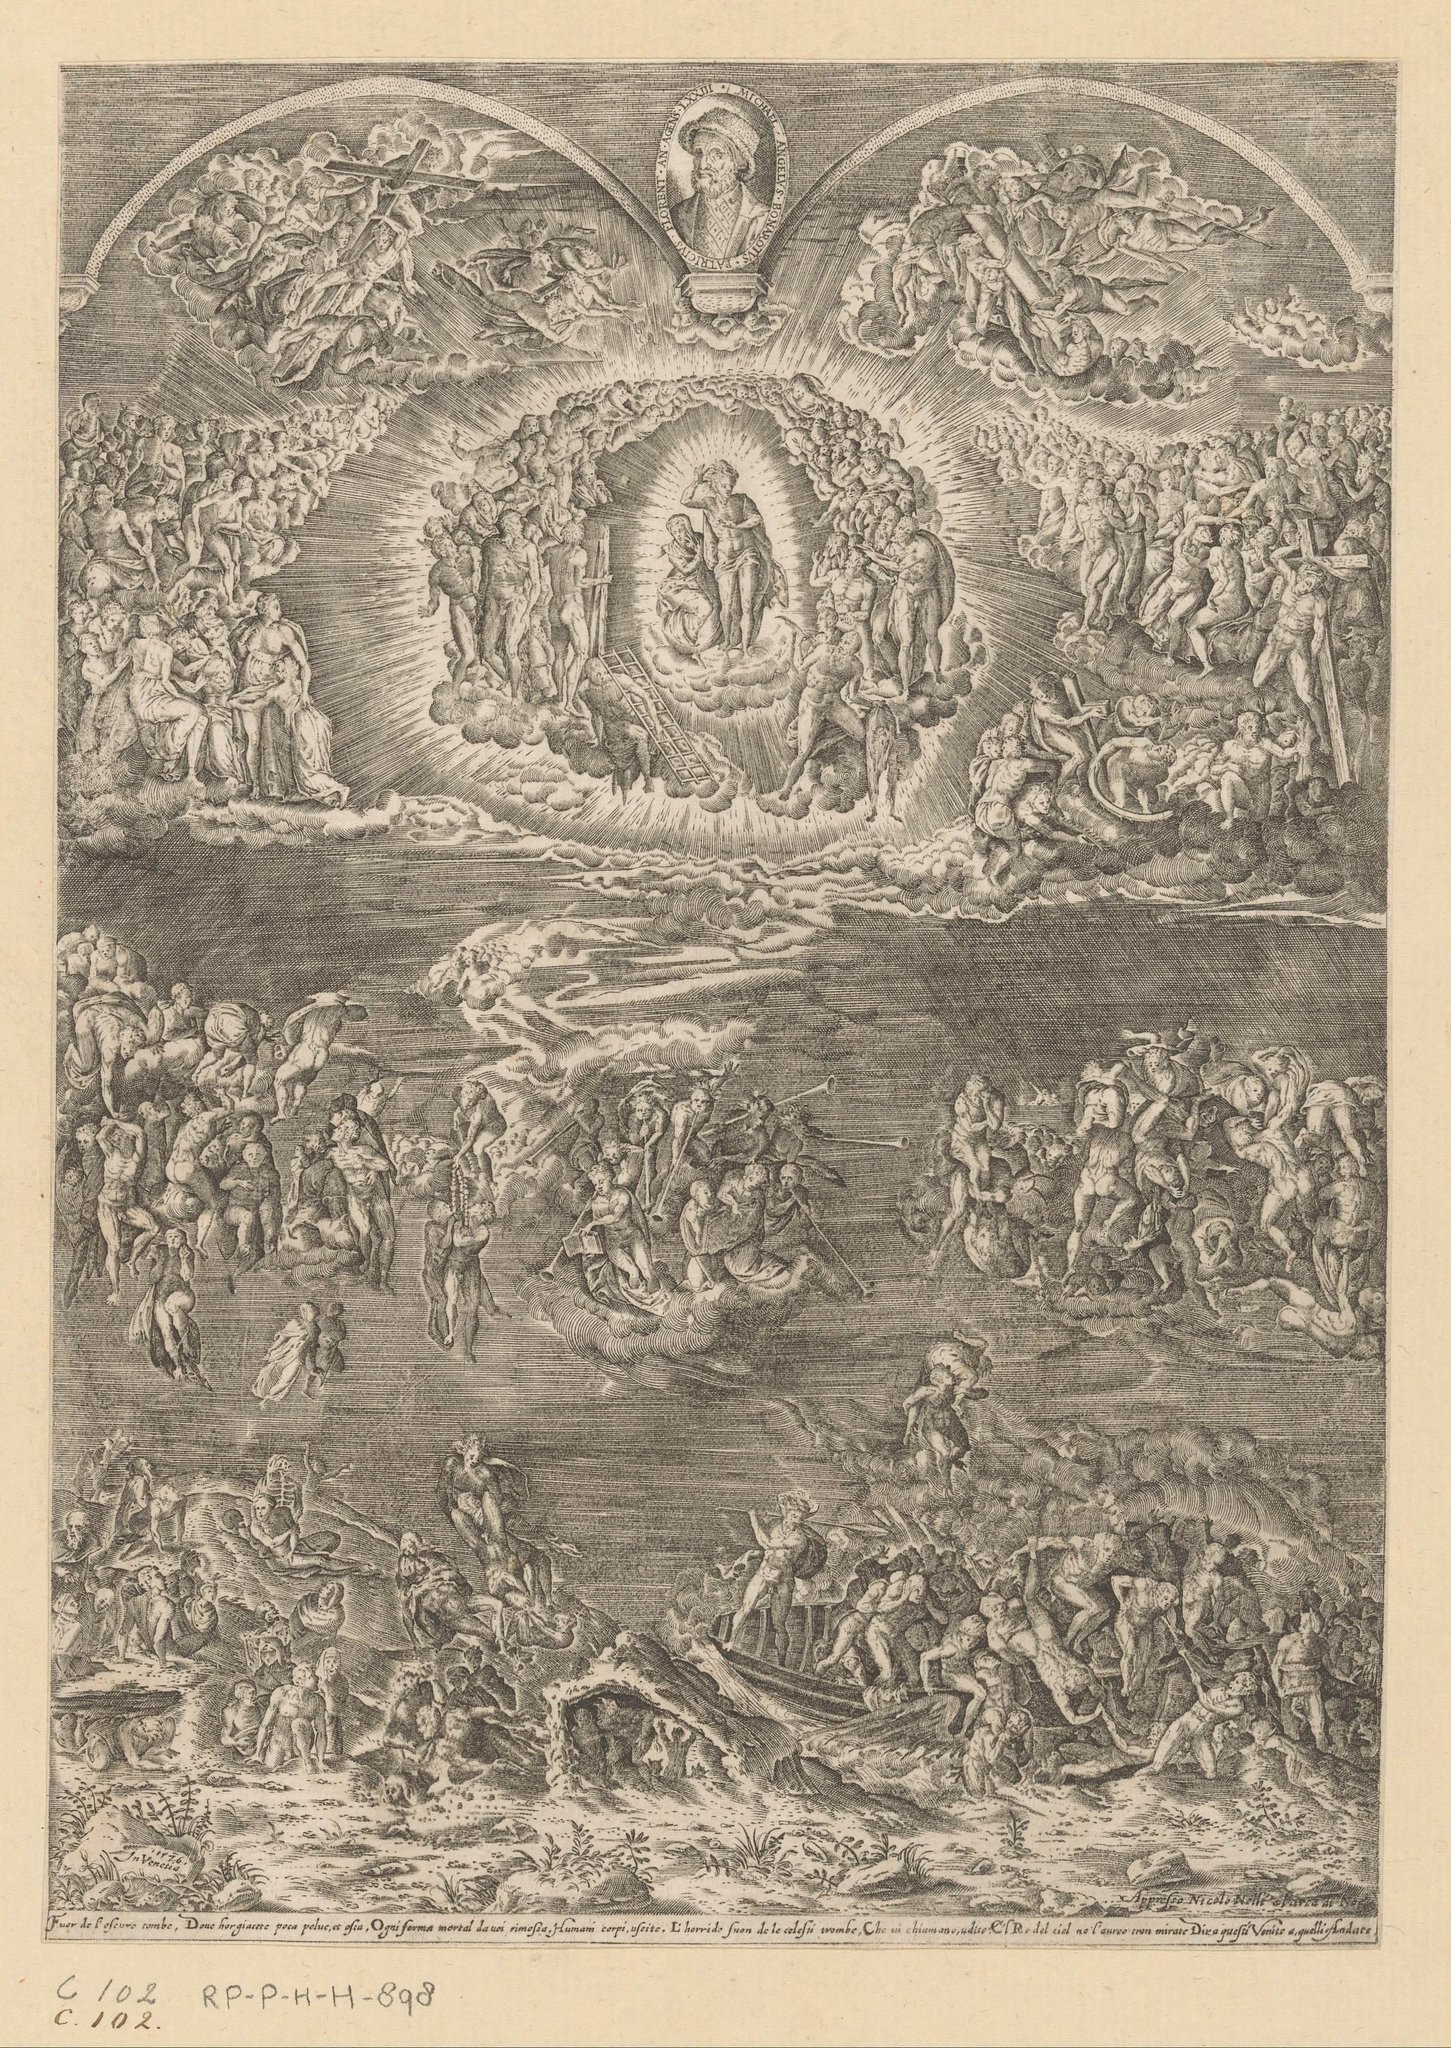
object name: print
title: Laatste Oordeel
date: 1576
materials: paper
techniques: engraving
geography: venice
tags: rome, painter, draughtsman, sculptor, michelangelo, last judgement, portrait, self-portrait of artist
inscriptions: collector's mark: Lugt 11, collector's mark: ‘Hinloopen’, collector's mark: Lugt 10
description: Het fresco 'Het laatste oordeel' door Michelangelo in de Sixtijnse Kapel. Bovenaan tussen de twee bogen het portret van Michelangelo, op 73-jarige leeftijd.